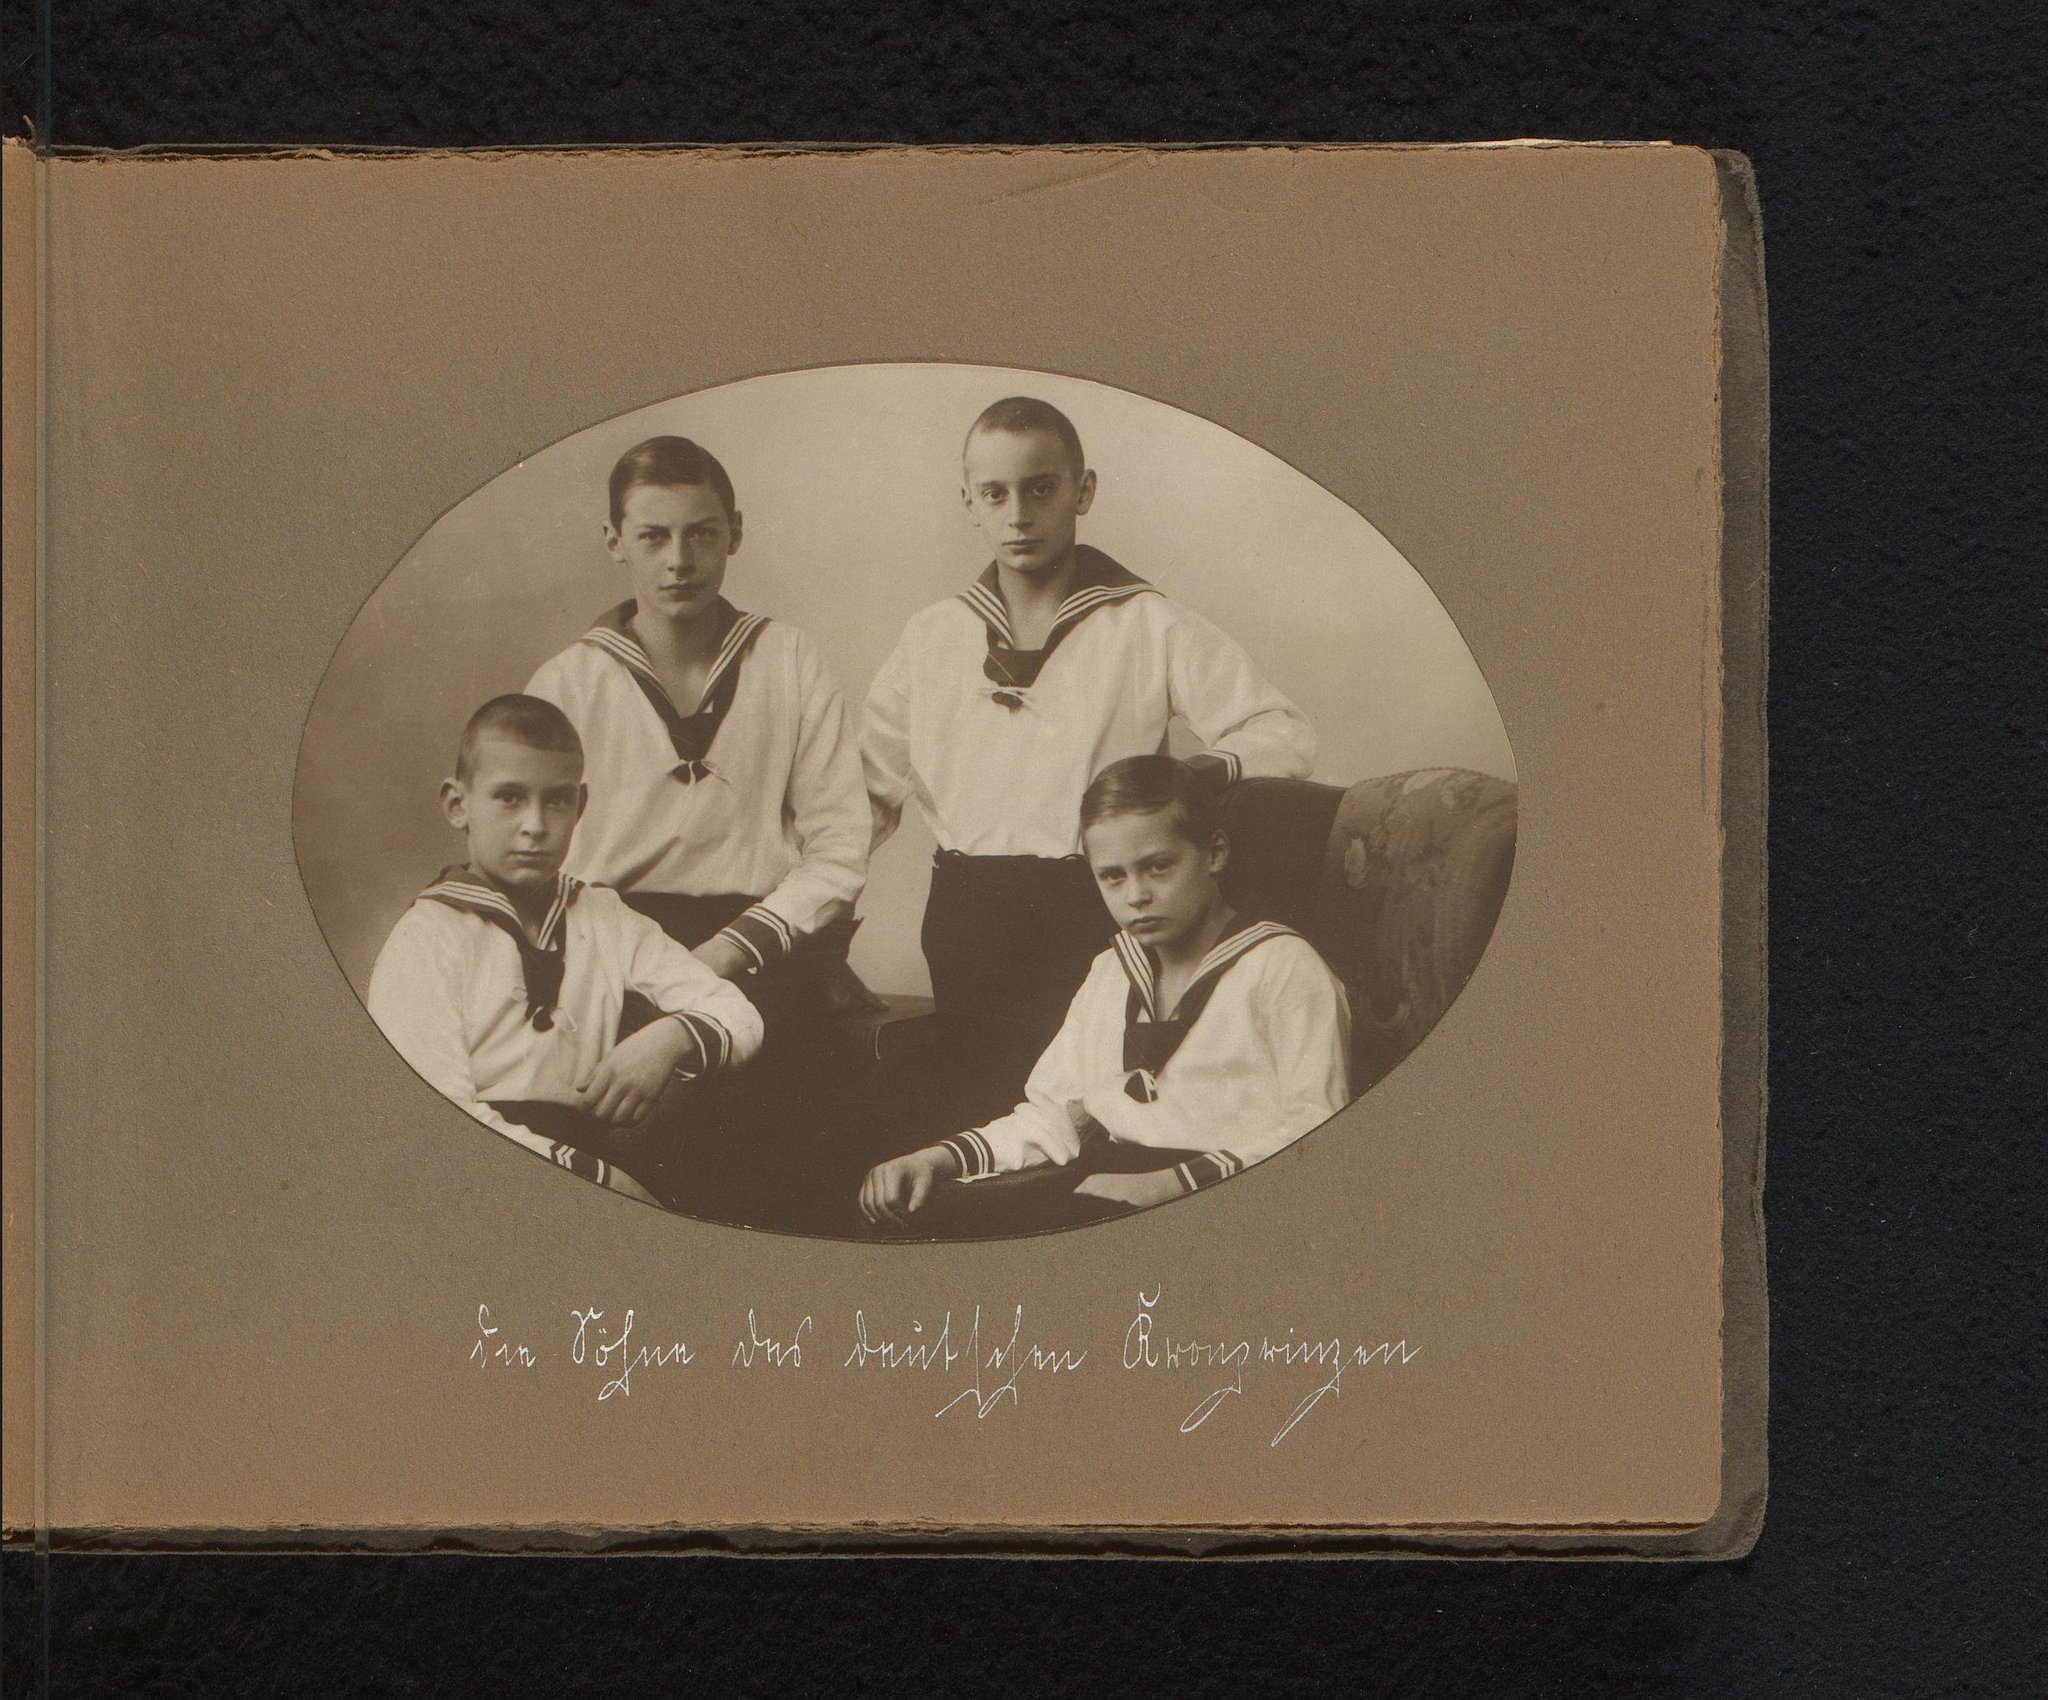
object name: album leaf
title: Groepsportret van Wilhelm van Pruisen, Louis Ferdinand van Pruisen, Hubertus van Pruisen en Frederik van Pruisen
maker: Anonymous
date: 1915-1925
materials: paper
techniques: gelatin silver print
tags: berlin, prince, anonymous historical persons portrayed in a group, in a group-portrait